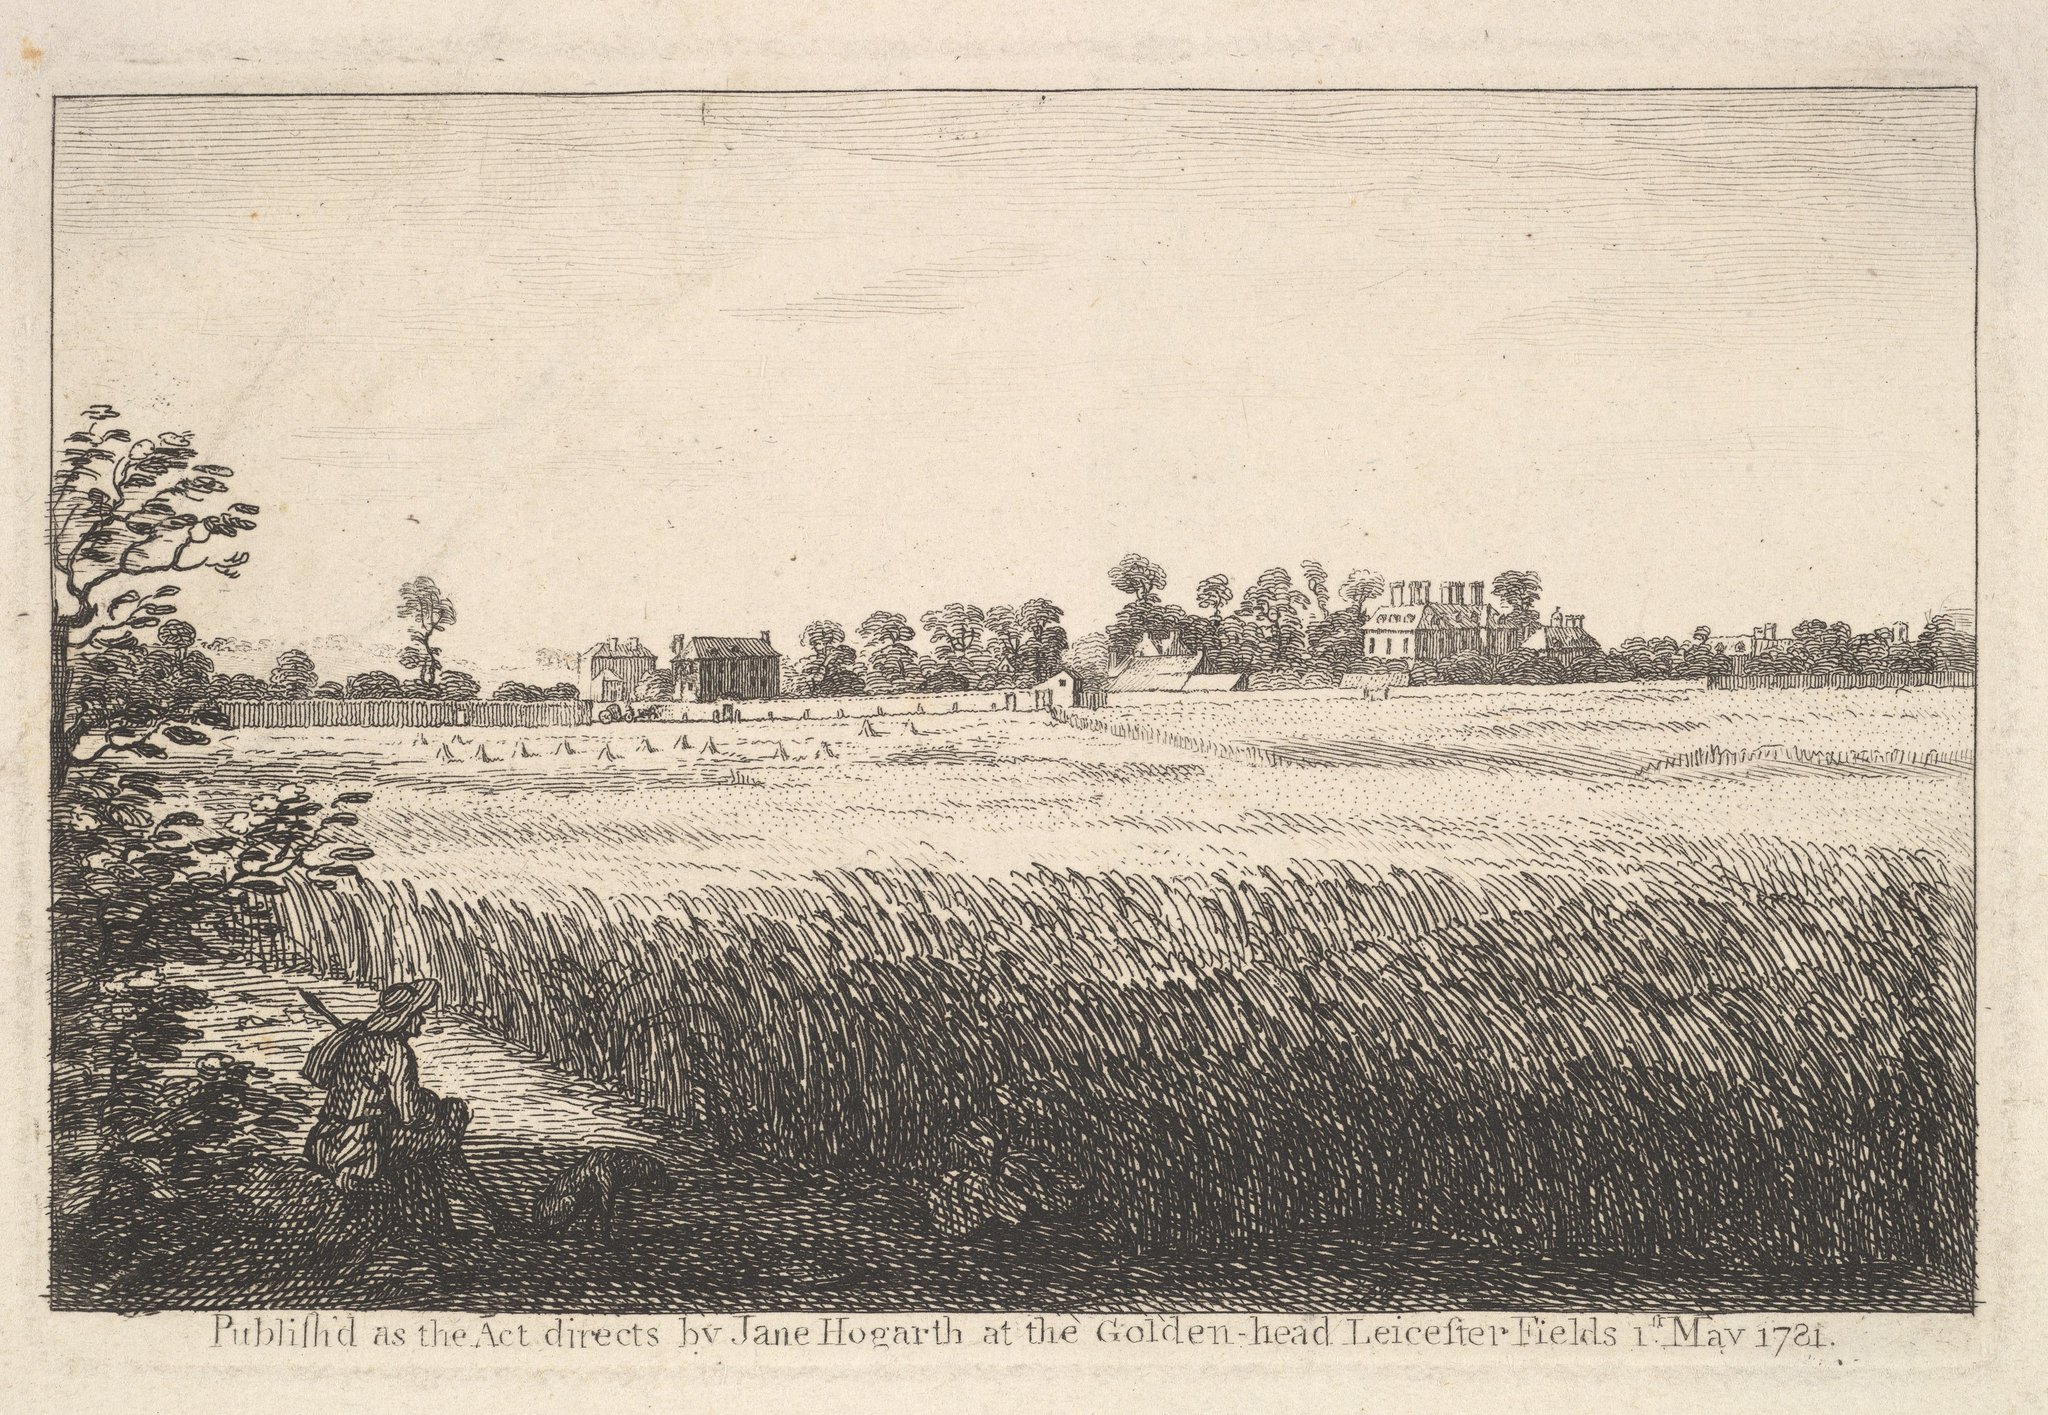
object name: print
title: View of Ranby's House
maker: william hogarth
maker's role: artist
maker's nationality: british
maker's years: 1697-1764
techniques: engraving, etching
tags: human figures,houses,landscapes